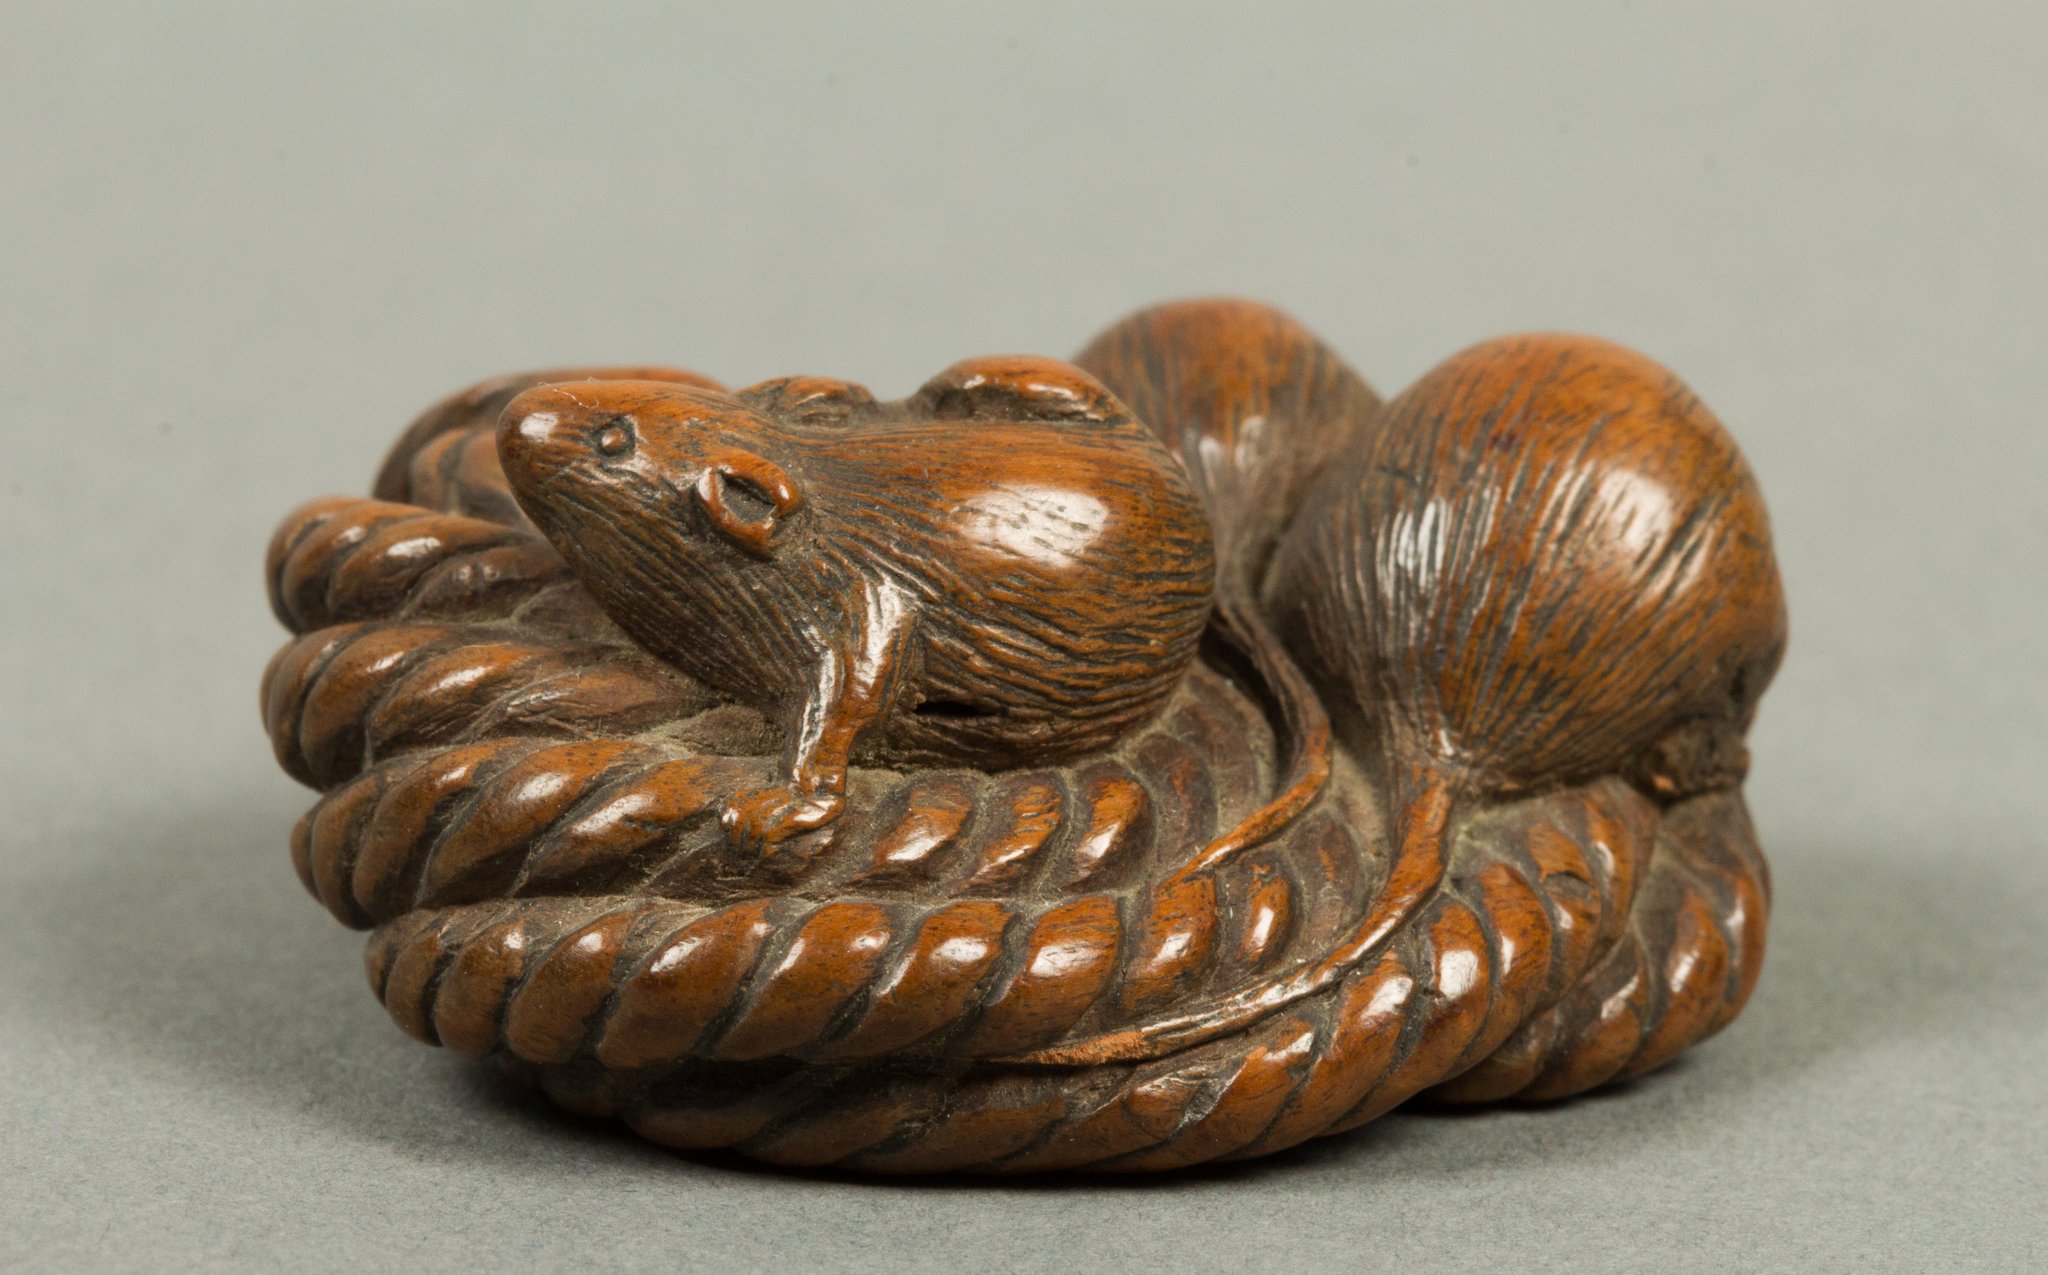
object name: netsuke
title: Netsuke of Three Mice on a Coil of Rope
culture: japanese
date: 1801-1900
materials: wood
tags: mice